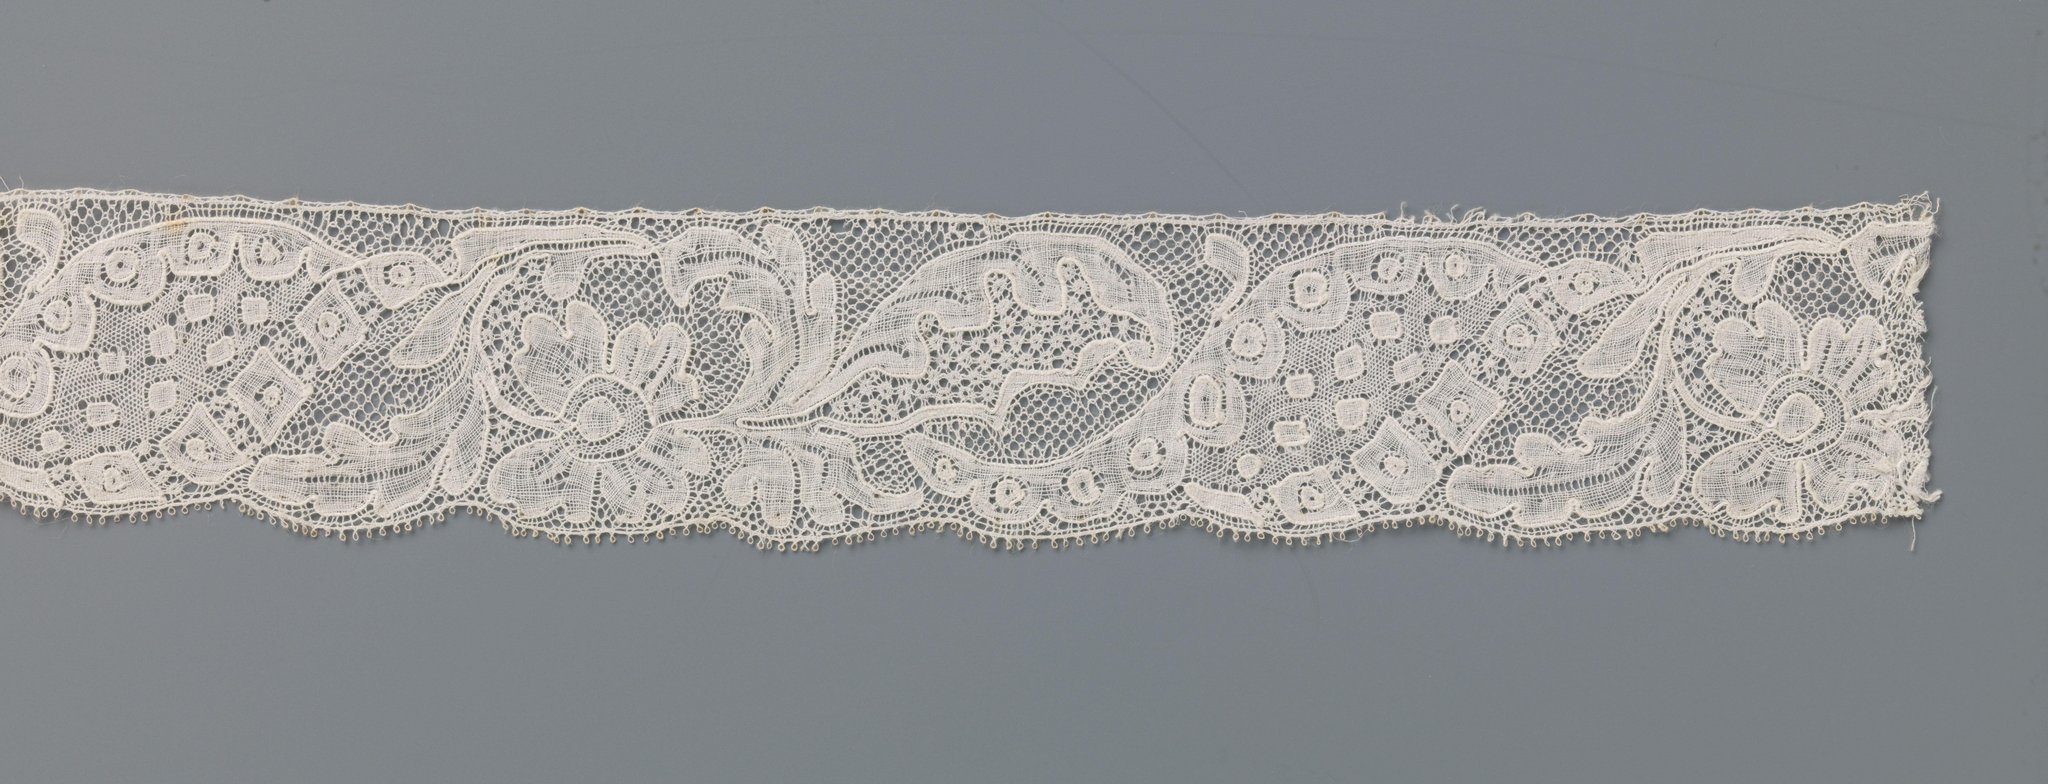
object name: strip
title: Strook kloskant met door bladeren omringde bloem en samengesteld bladvormig motief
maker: Anonymous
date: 1740-1760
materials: linen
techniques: lace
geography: mechelen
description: Strook naturelkleurige kloskant: Mechelse kant. Het zich herhalende patroon bestaat uit een grotendeels door bladeren omringde bloem afgewisseld door een groot bladvormig motief dat is samengesteld uit een rand van scheefgetrokken vierkantjes en een éénzijdig gelobde rand met in elke lob een cirkeltje. De motieven zijn met elkaar verbonden door een fijne maasgrond. De motieven zijn gemaakt in linnenslag met uitsparingen en netslag, met dikkere en glimmende contourdraden. In en tussen verschillende motieven is een siergrond toegepast, een sneeuwvlokkengrond. De zeer flauw geschulpte onderzijde is afgewerkt met picots. De bovenzijde is recht afgewerkt. De strook bestaat uit drie, met grove naden aan elkaar genaaide stukken. Met één kort stukje aan de linkerkant, gevolgd door twee min of meer gelijke stukken met in het midden een as van symmetrie.